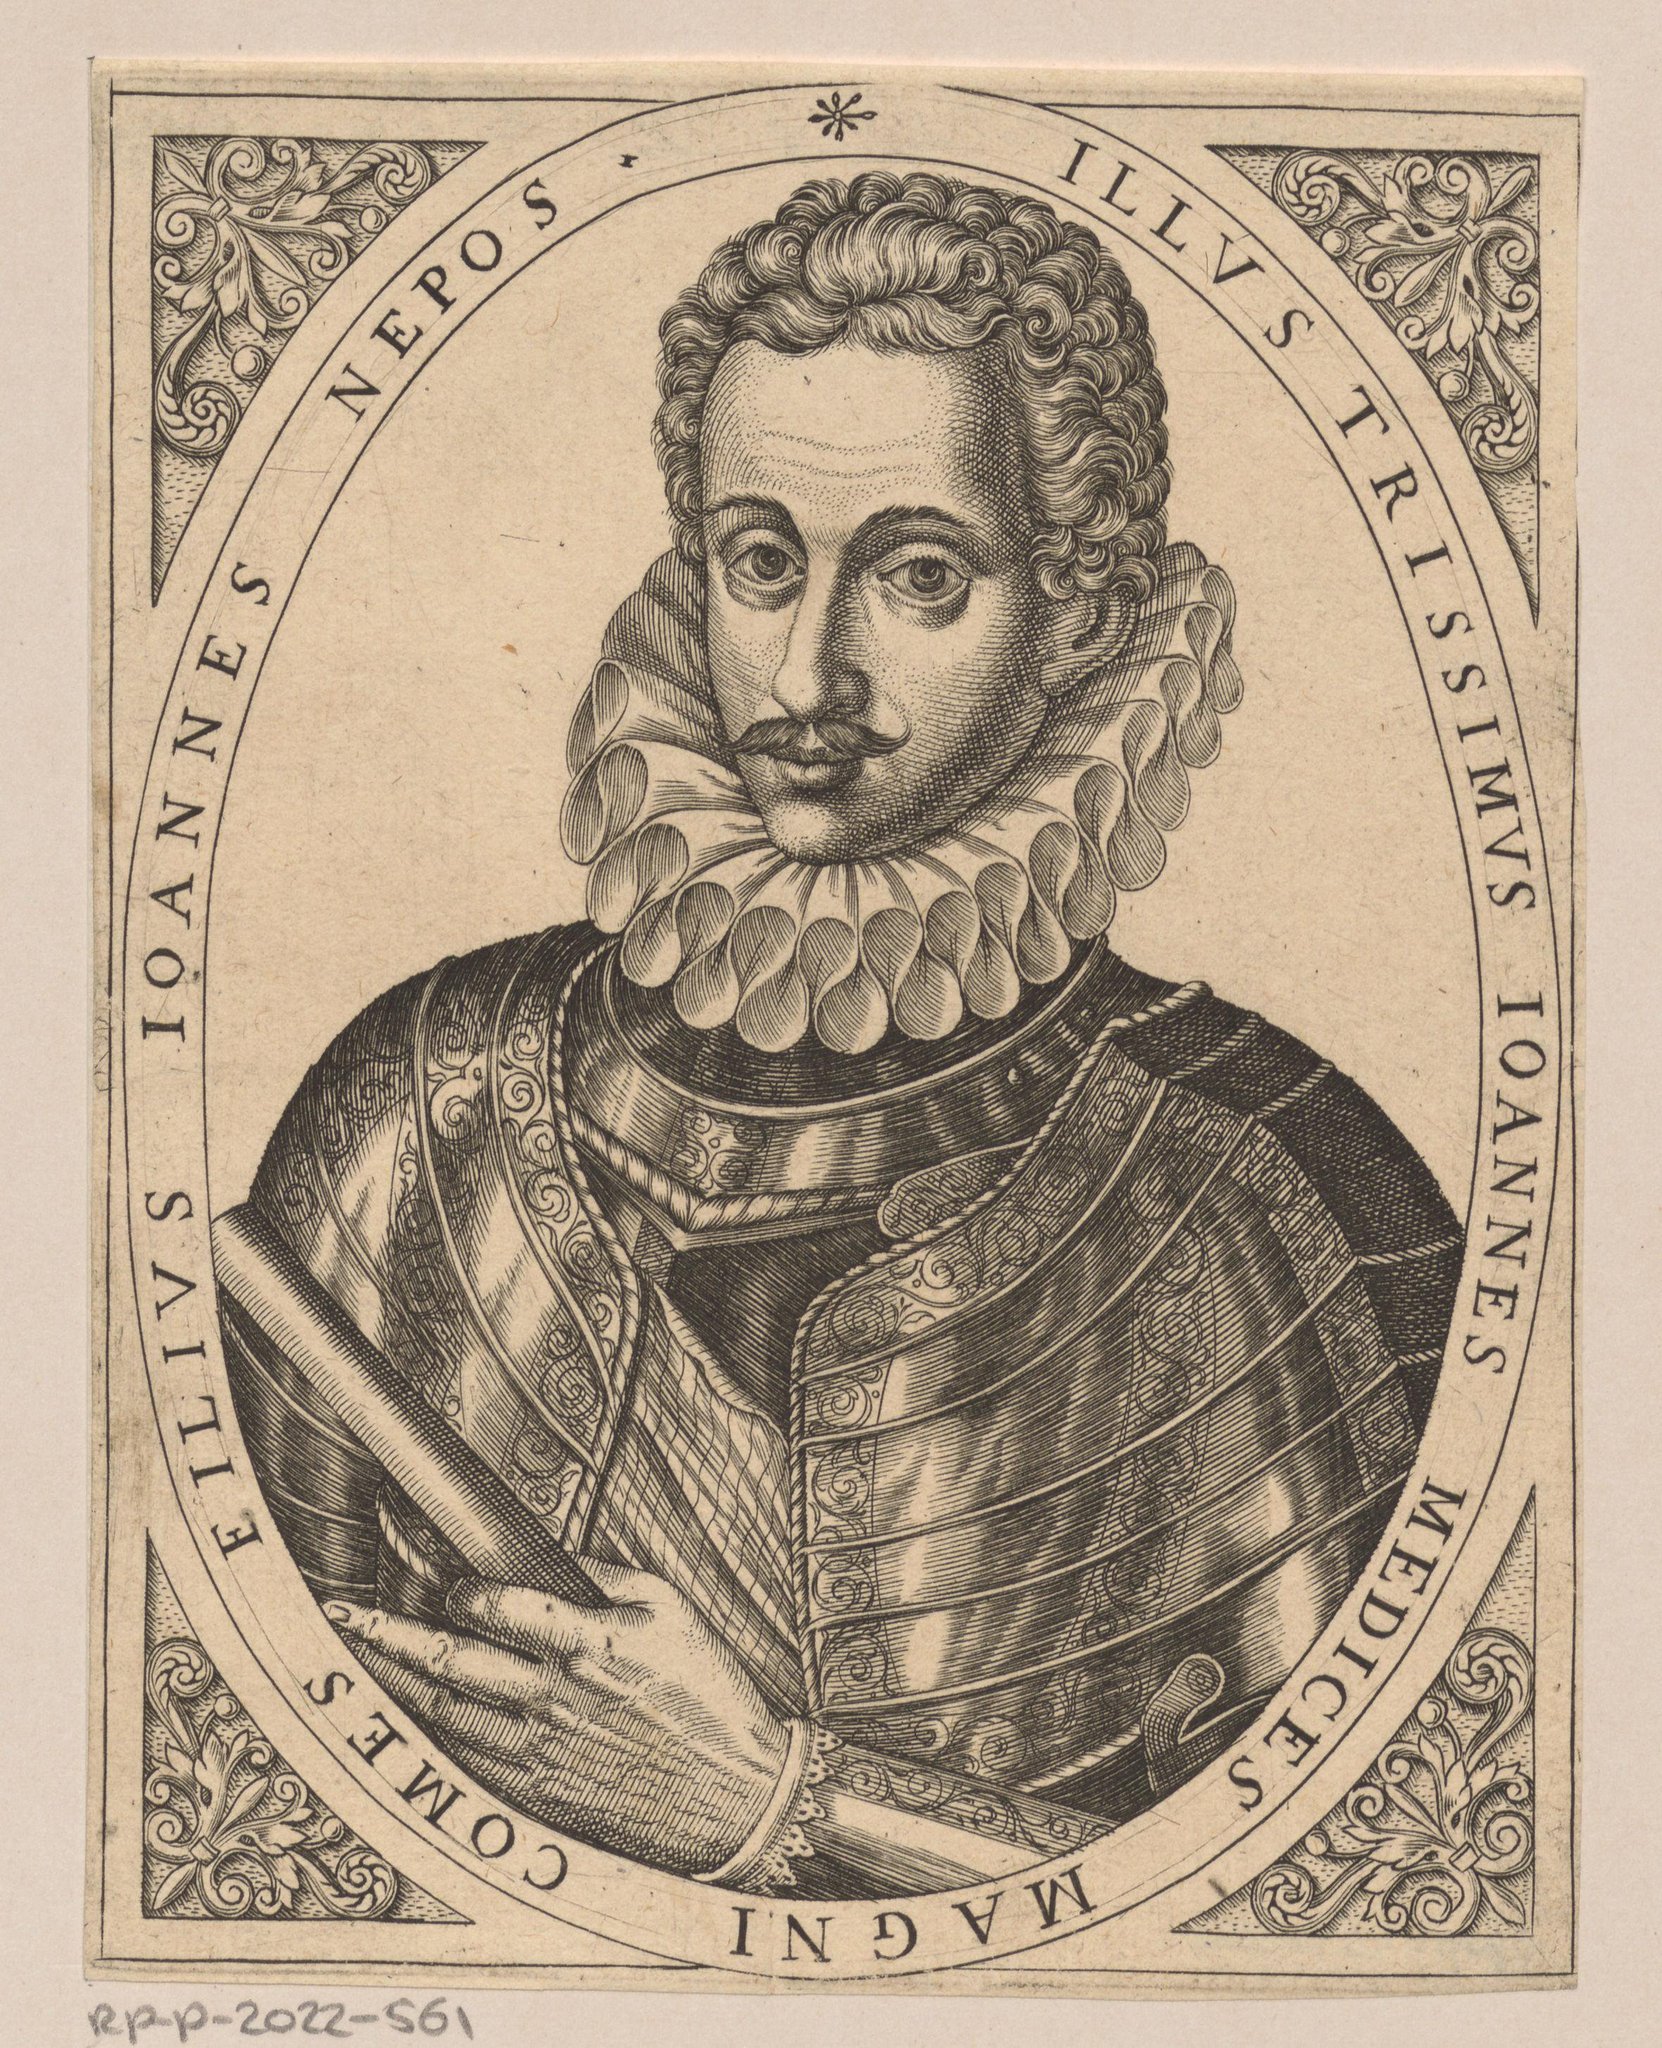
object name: print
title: Portret van Don Giovanni de' Medici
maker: Anonymous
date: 1600-1700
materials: paper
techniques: engraving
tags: don giovanni de' medici, historical persons